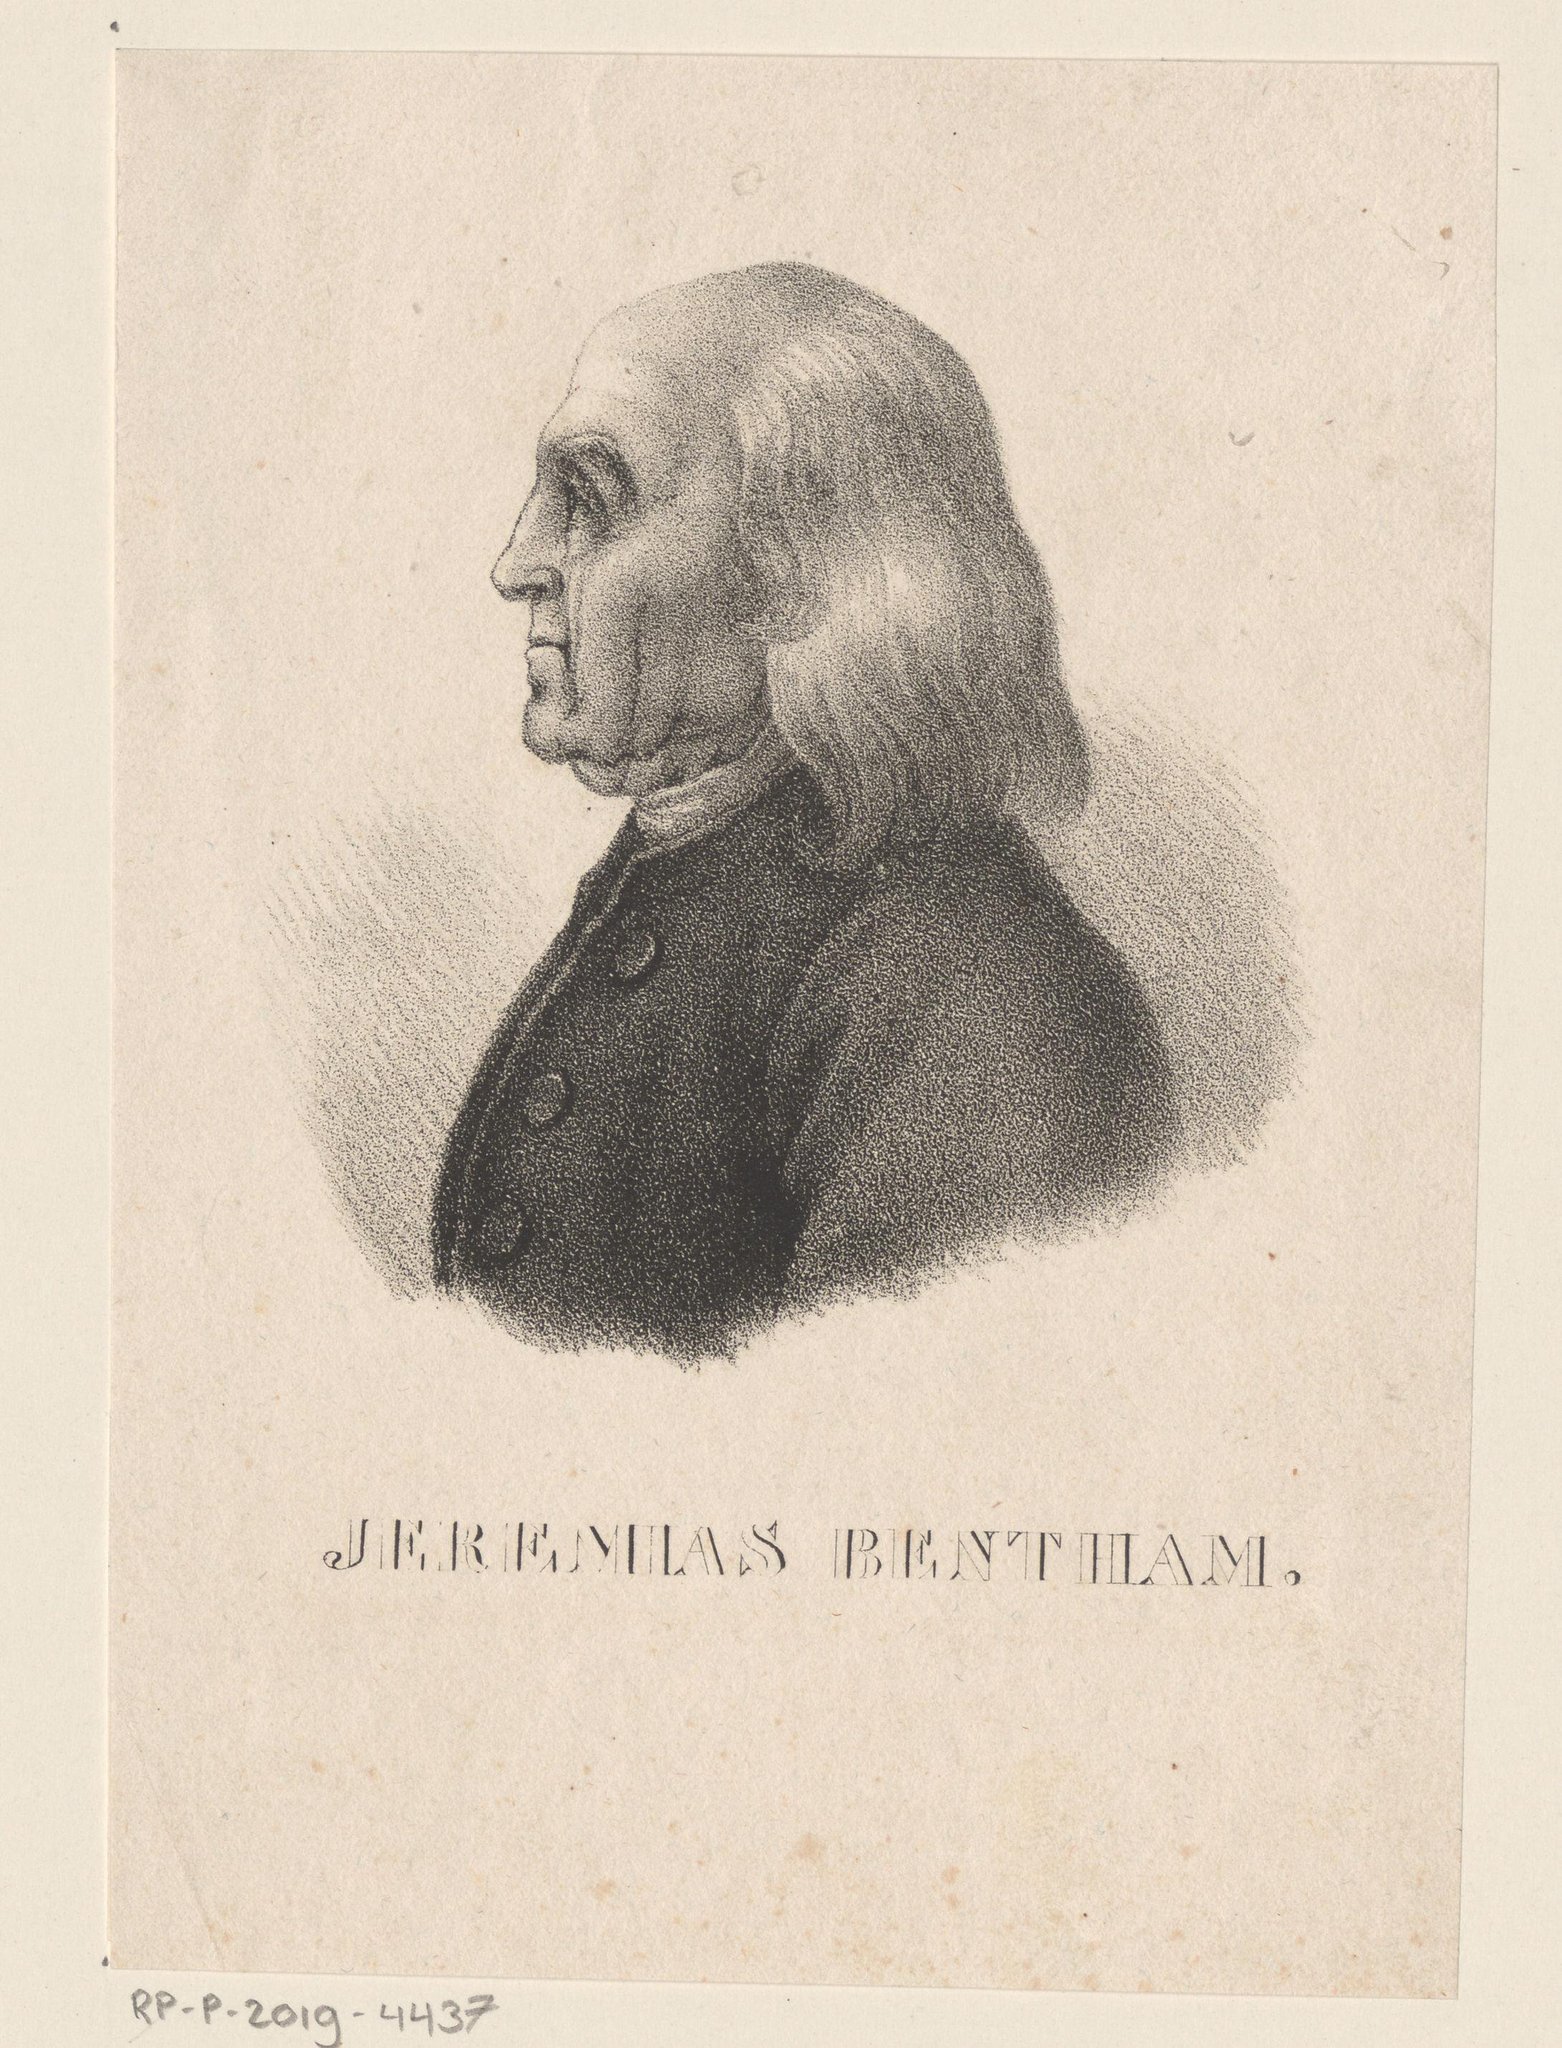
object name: print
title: Portret van Jeremy Bentham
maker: Anonymous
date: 1800-1849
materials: paper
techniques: lithograph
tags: london, historical persons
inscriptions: collector's mark: Lugt 2228